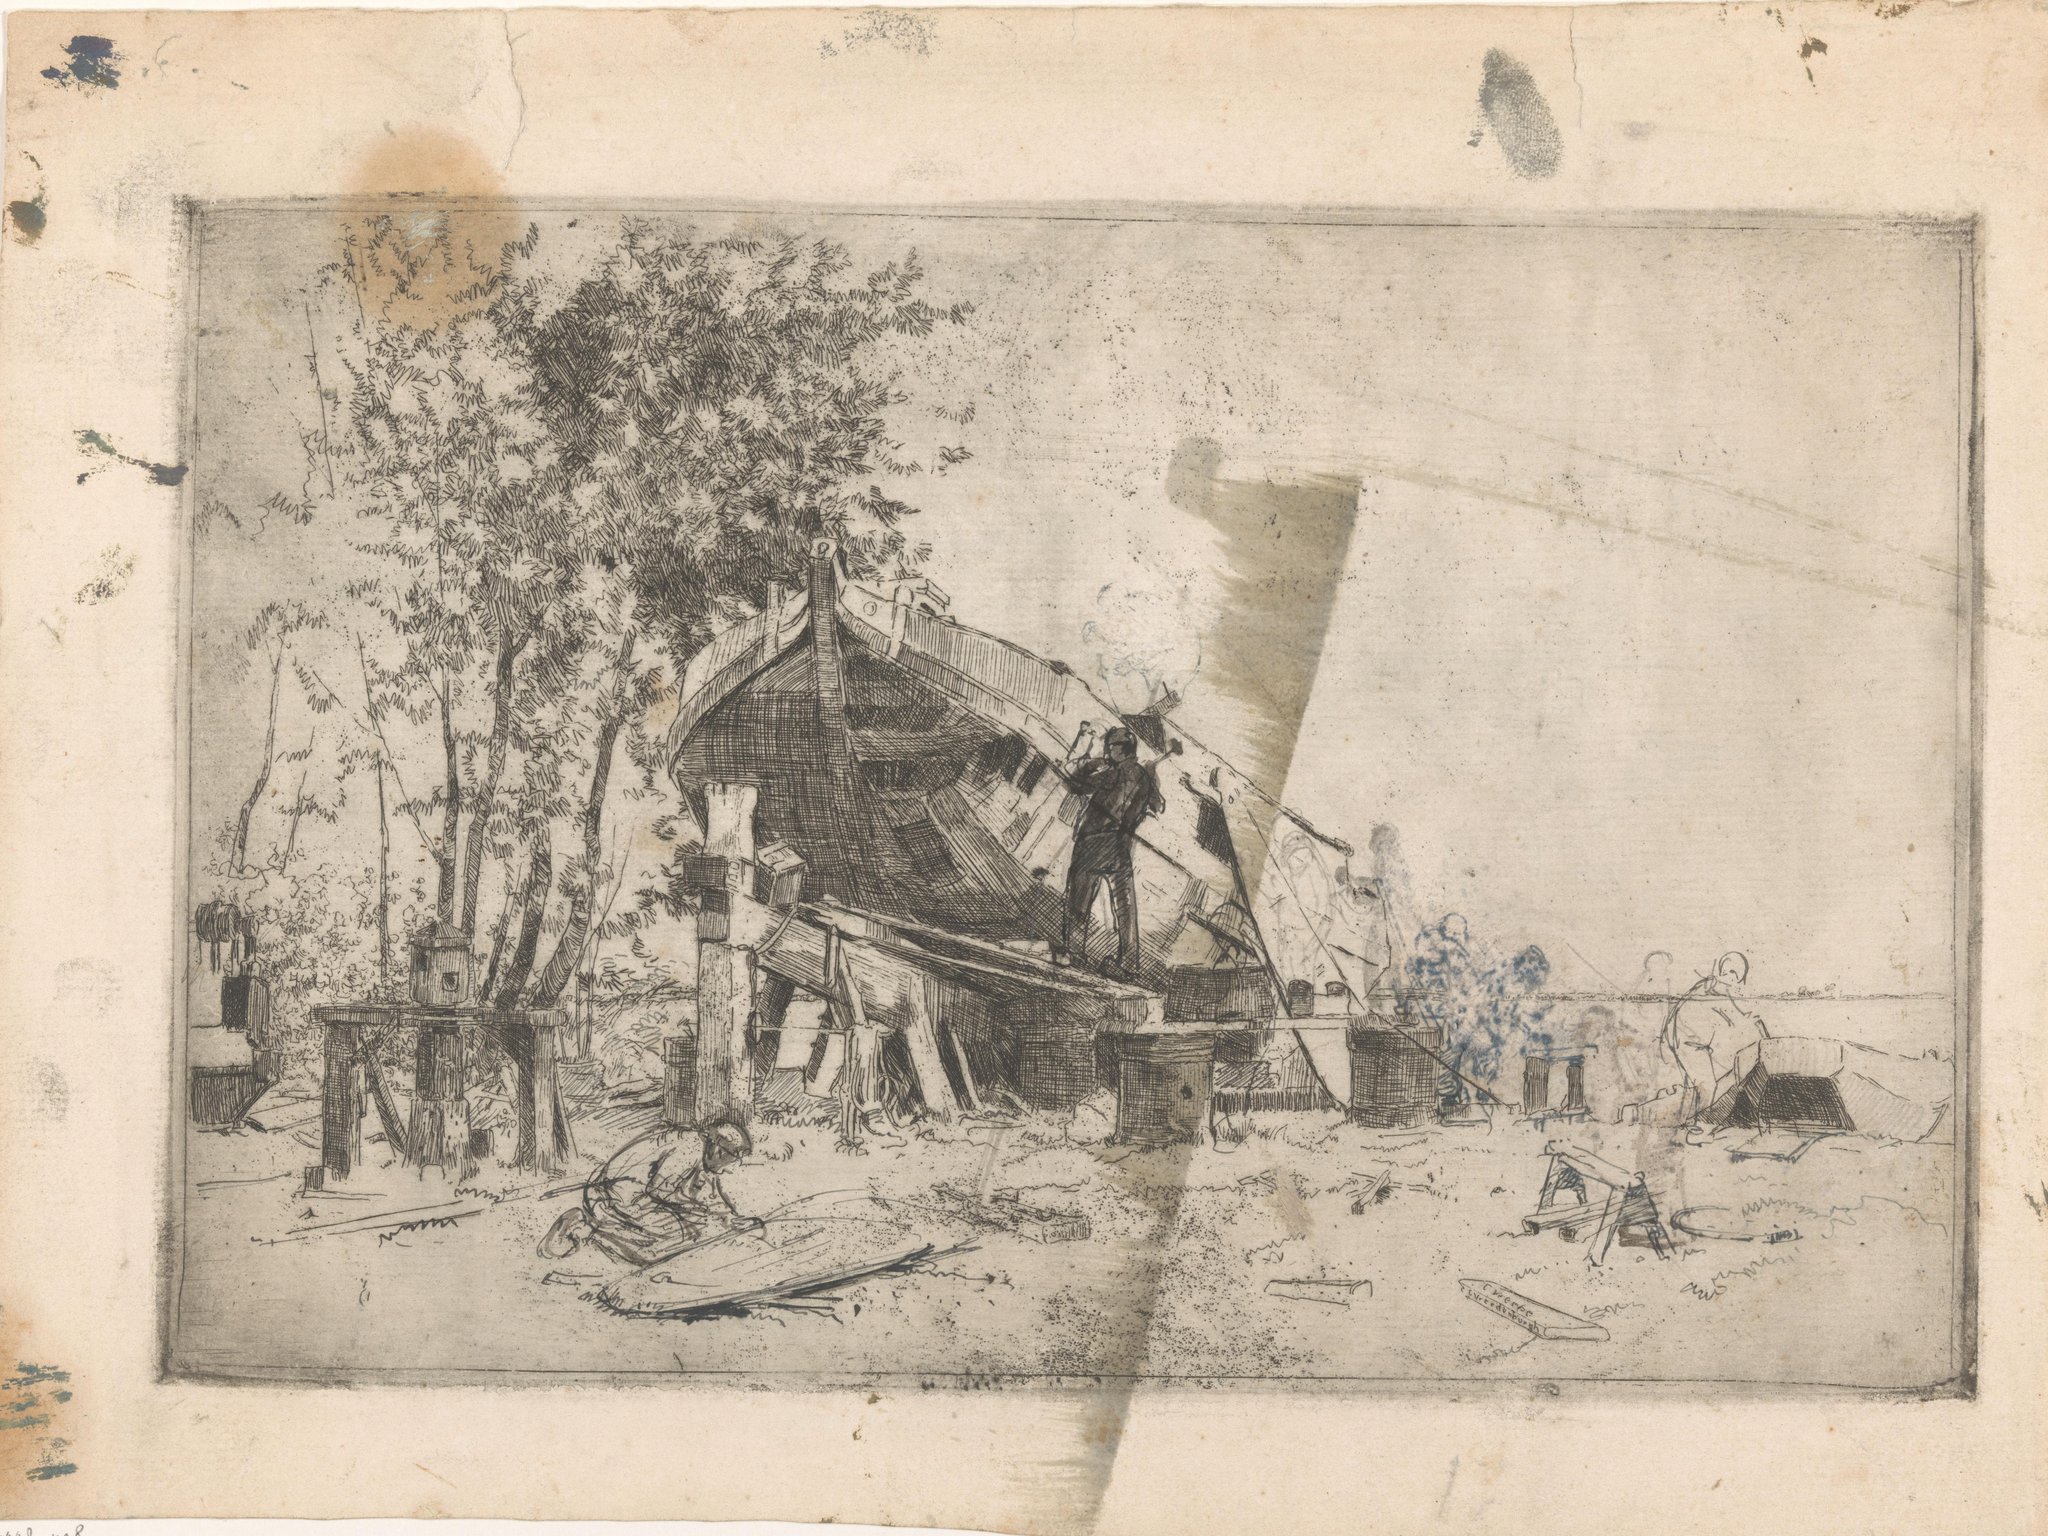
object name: print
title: Scheepswerf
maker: cornelis vreedenburgh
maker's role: draughtsman, print maker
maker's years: 1880-1946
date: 1890-1946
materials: ink, paper, pencil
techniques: brush, etching, intaglio, pen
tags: pier, quay, wharf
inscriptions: collector's mark: Lugt 2760, collector's mark: Lugt 2228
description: Scheepswerf met houten boot liggend onder de bomen. In het water een roeiboot. Met potlood en inkt zijn enkele werkende figuren en een houten schraag toegevoegd.